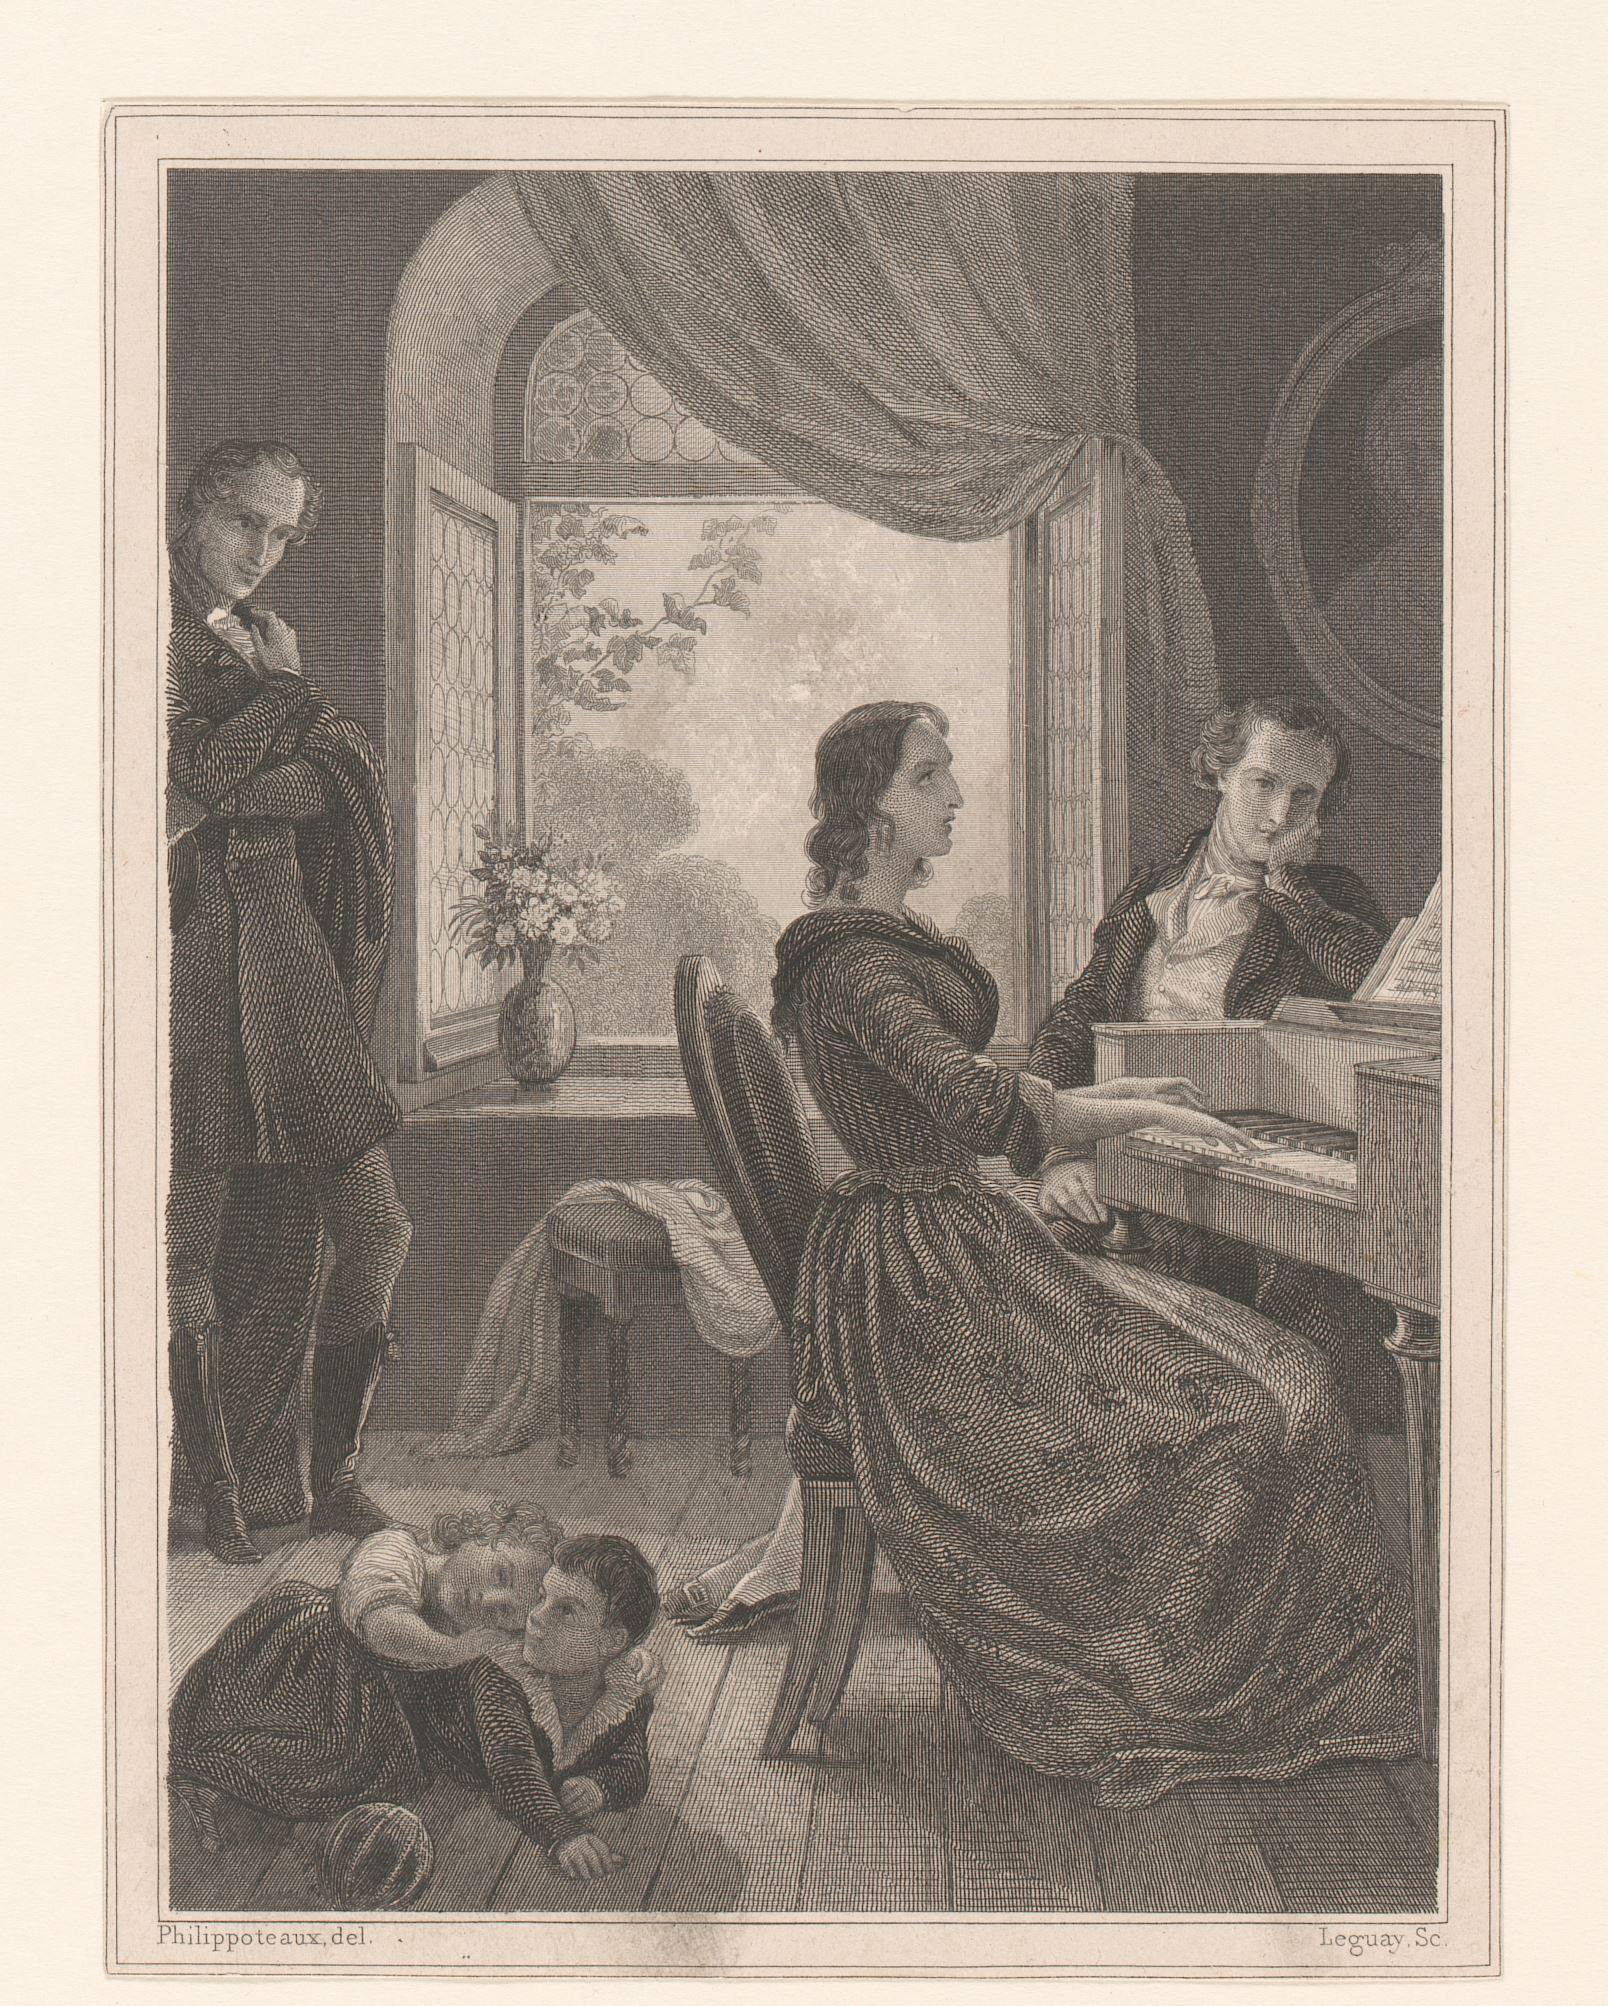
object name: print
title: Interieur met pianospelende vrouw, twee luisterende mannen en twee spelende kinderen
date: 1832-1905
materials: paper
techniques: engraving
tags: grand piano, interior of the house, one person playing an instrument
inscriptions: collector's mark: Lugt 2228